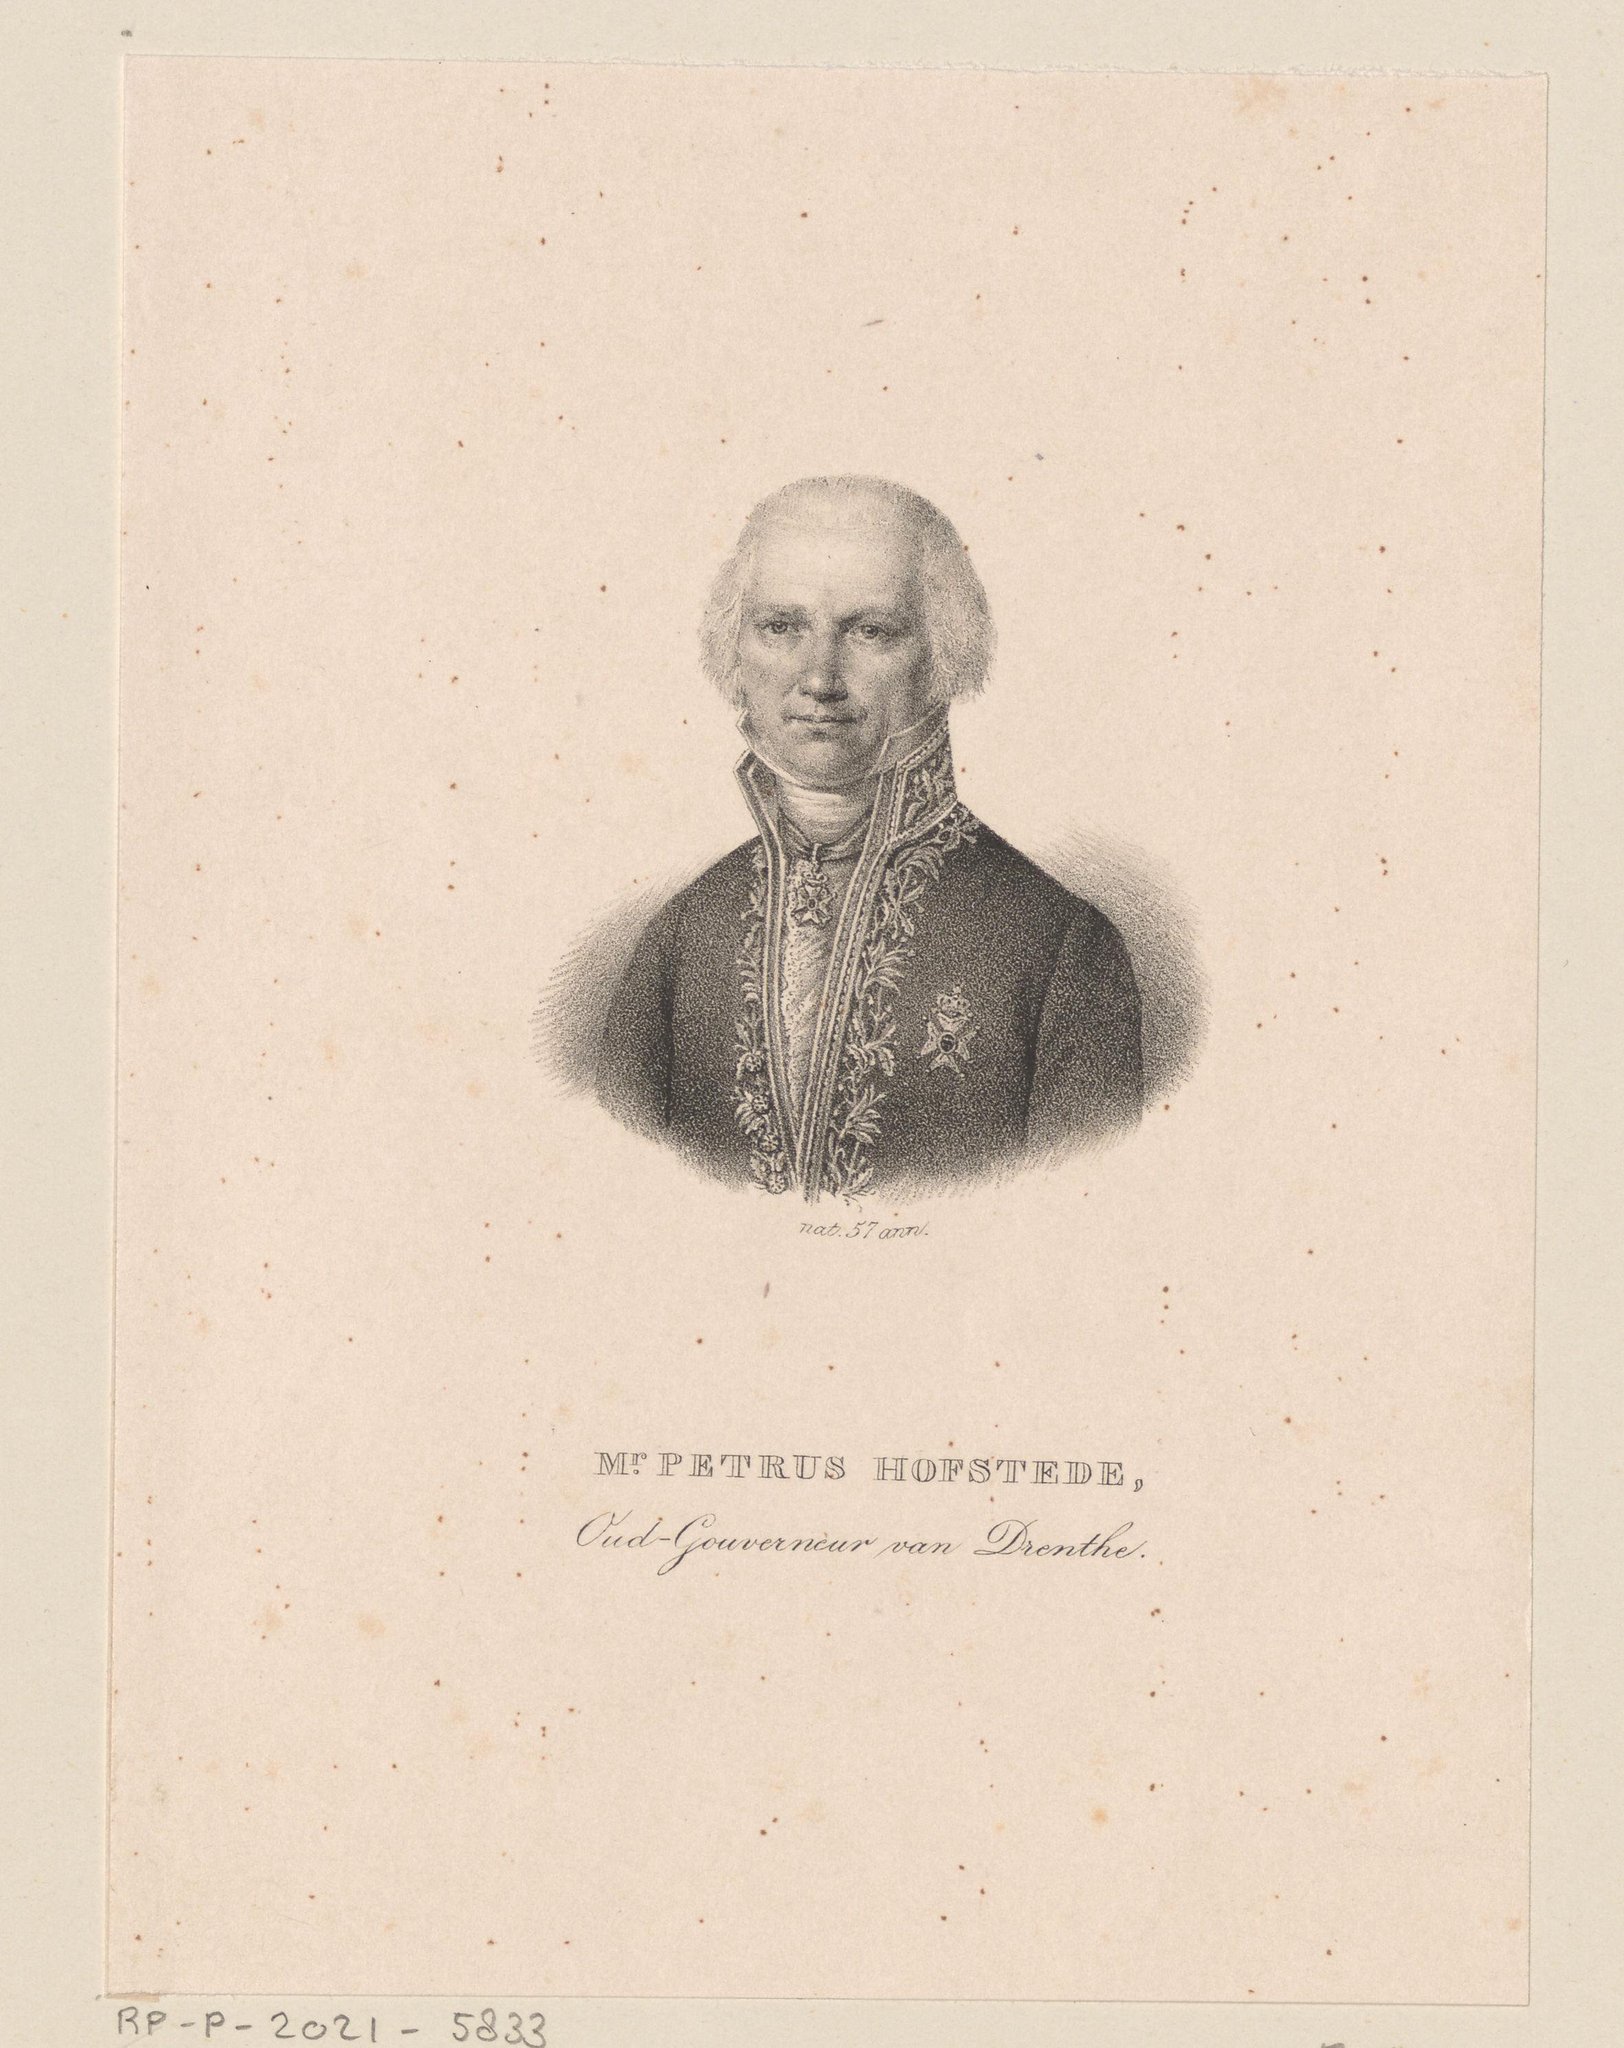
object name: print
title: Portret van Petrus Hofstede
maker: Anonymous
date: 1831-1850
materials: paper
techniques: lithograph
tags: groningen (province), politician, historical persons, governor, etc. of province